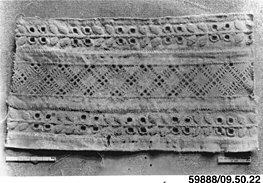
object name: fragment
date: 1601-1700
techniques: lace